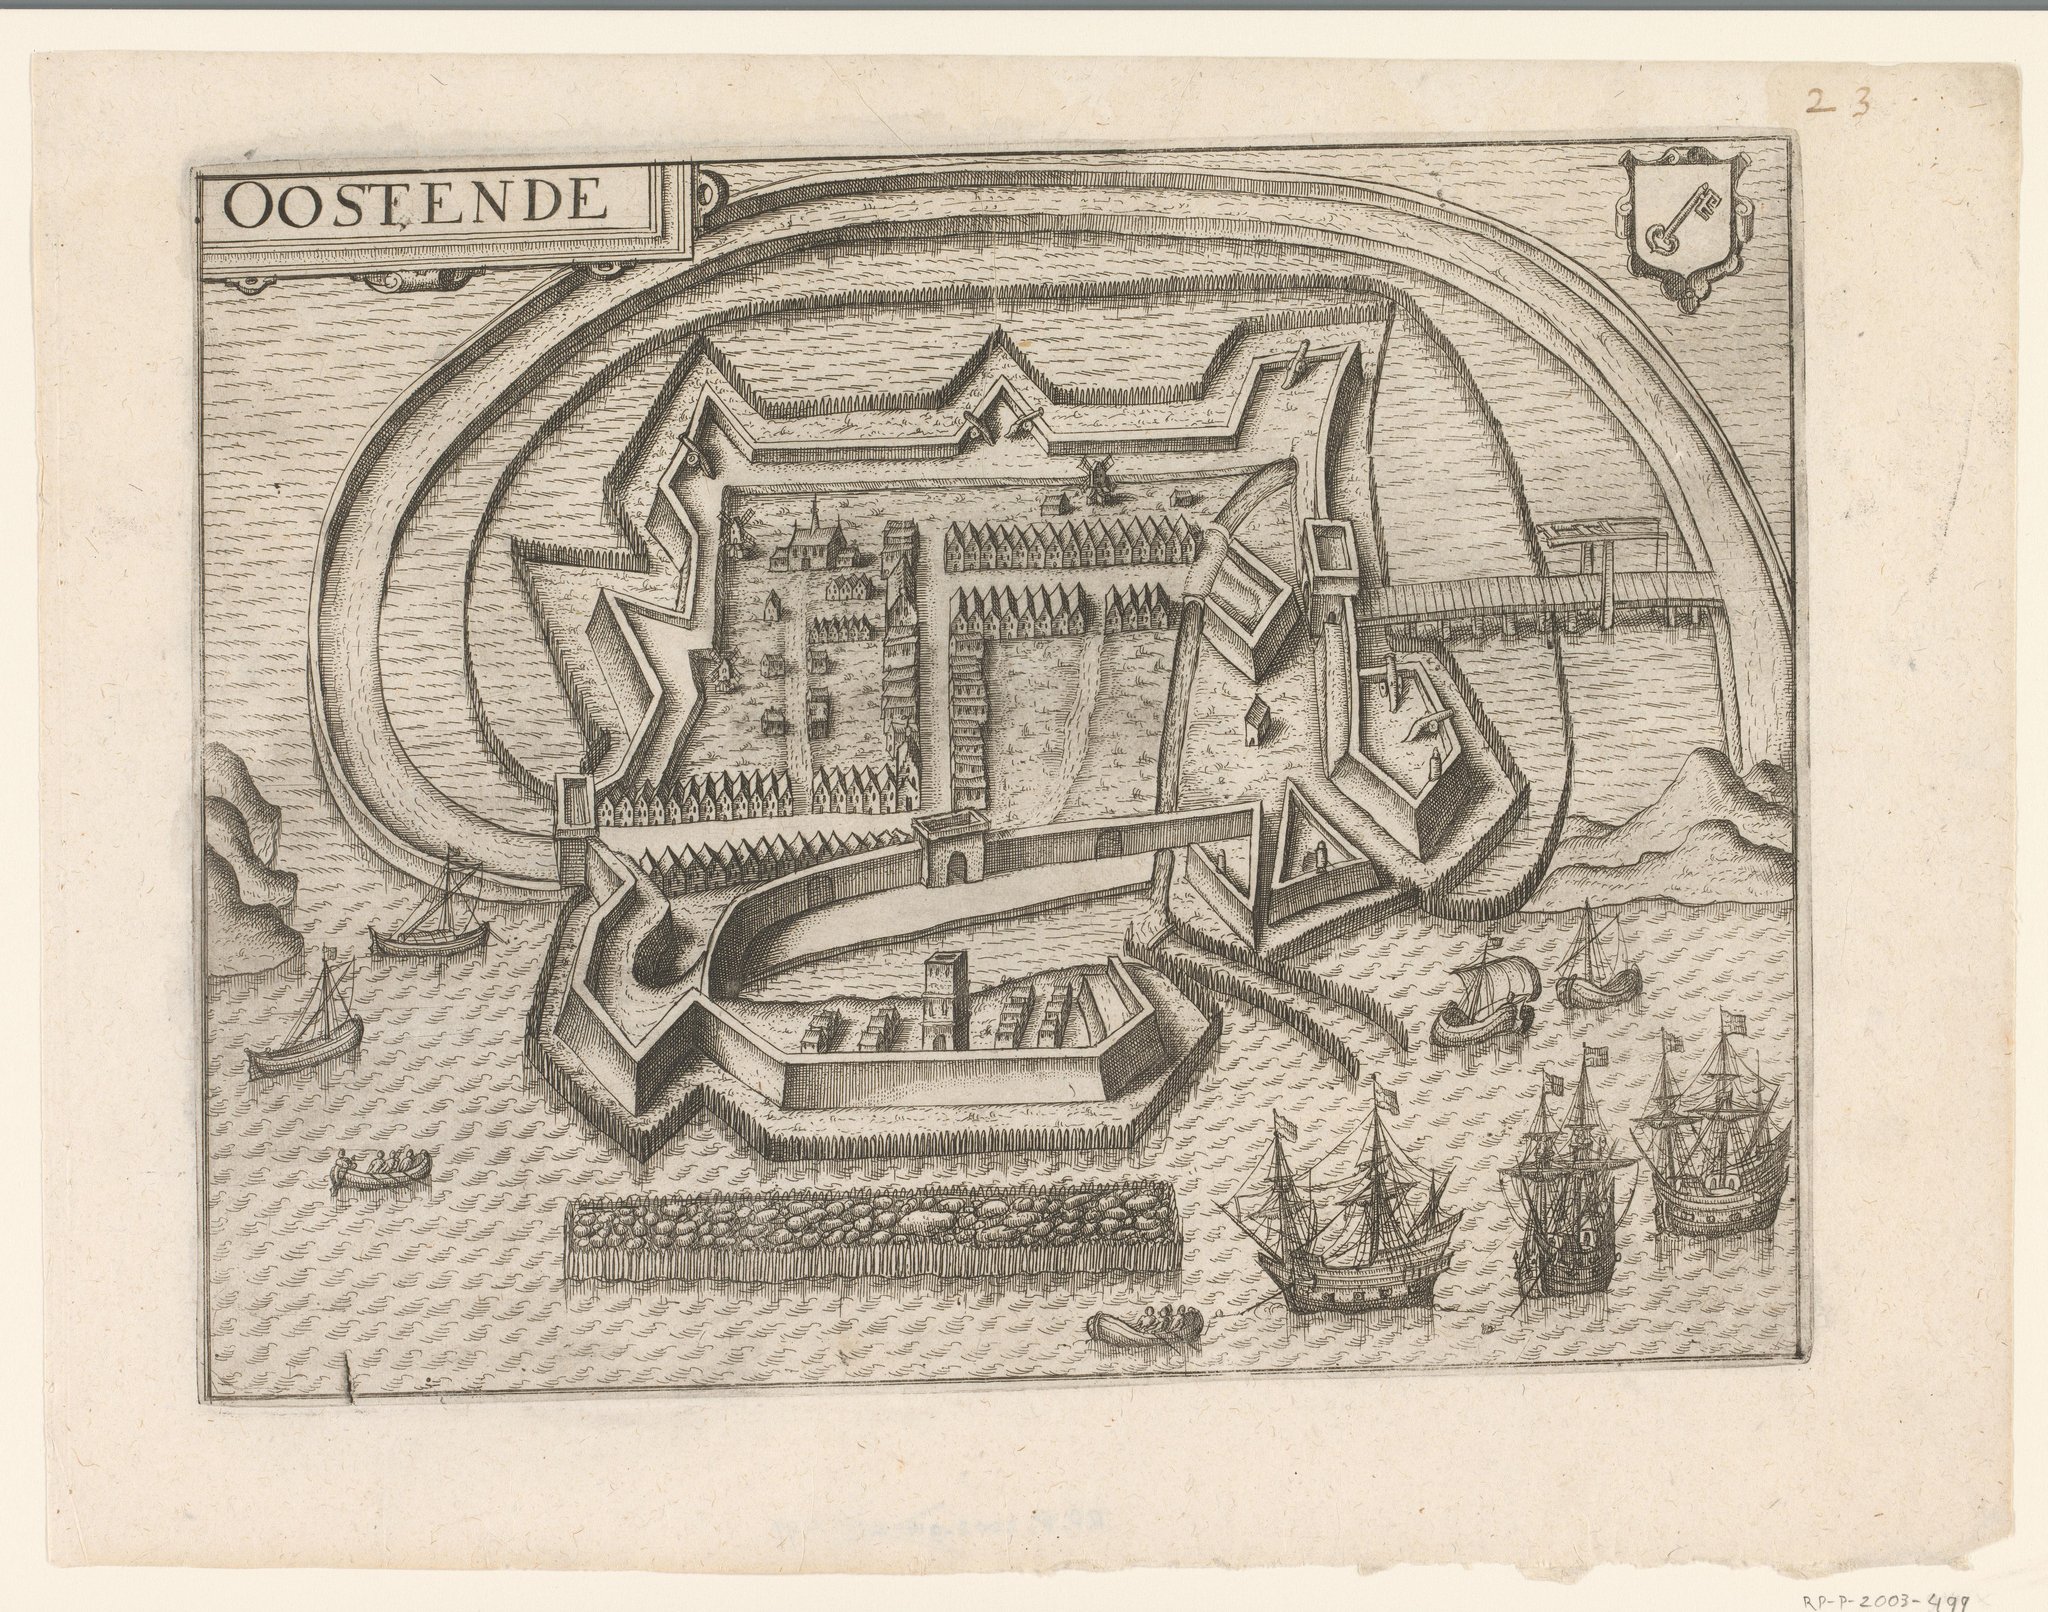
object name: print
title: Plattegrond van Oostende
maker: Anonymous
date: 1607-1609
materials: paper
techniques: etching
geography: northern netherlands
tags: sailing-ship, sailing-boat, maps of cities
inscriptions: number: ‘23’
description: Plattegrond van de stad Oostende. Linksboven een cartouche met de titel, rechtsboven het stadswapen. Voor de stad liggen verschillende schepen en sloepen. Onderdeel van de verzameling kaarten genomen uit een latere editie van: Descrittione di tutti i Paesi Bassi van Lodovico Guicciardini.